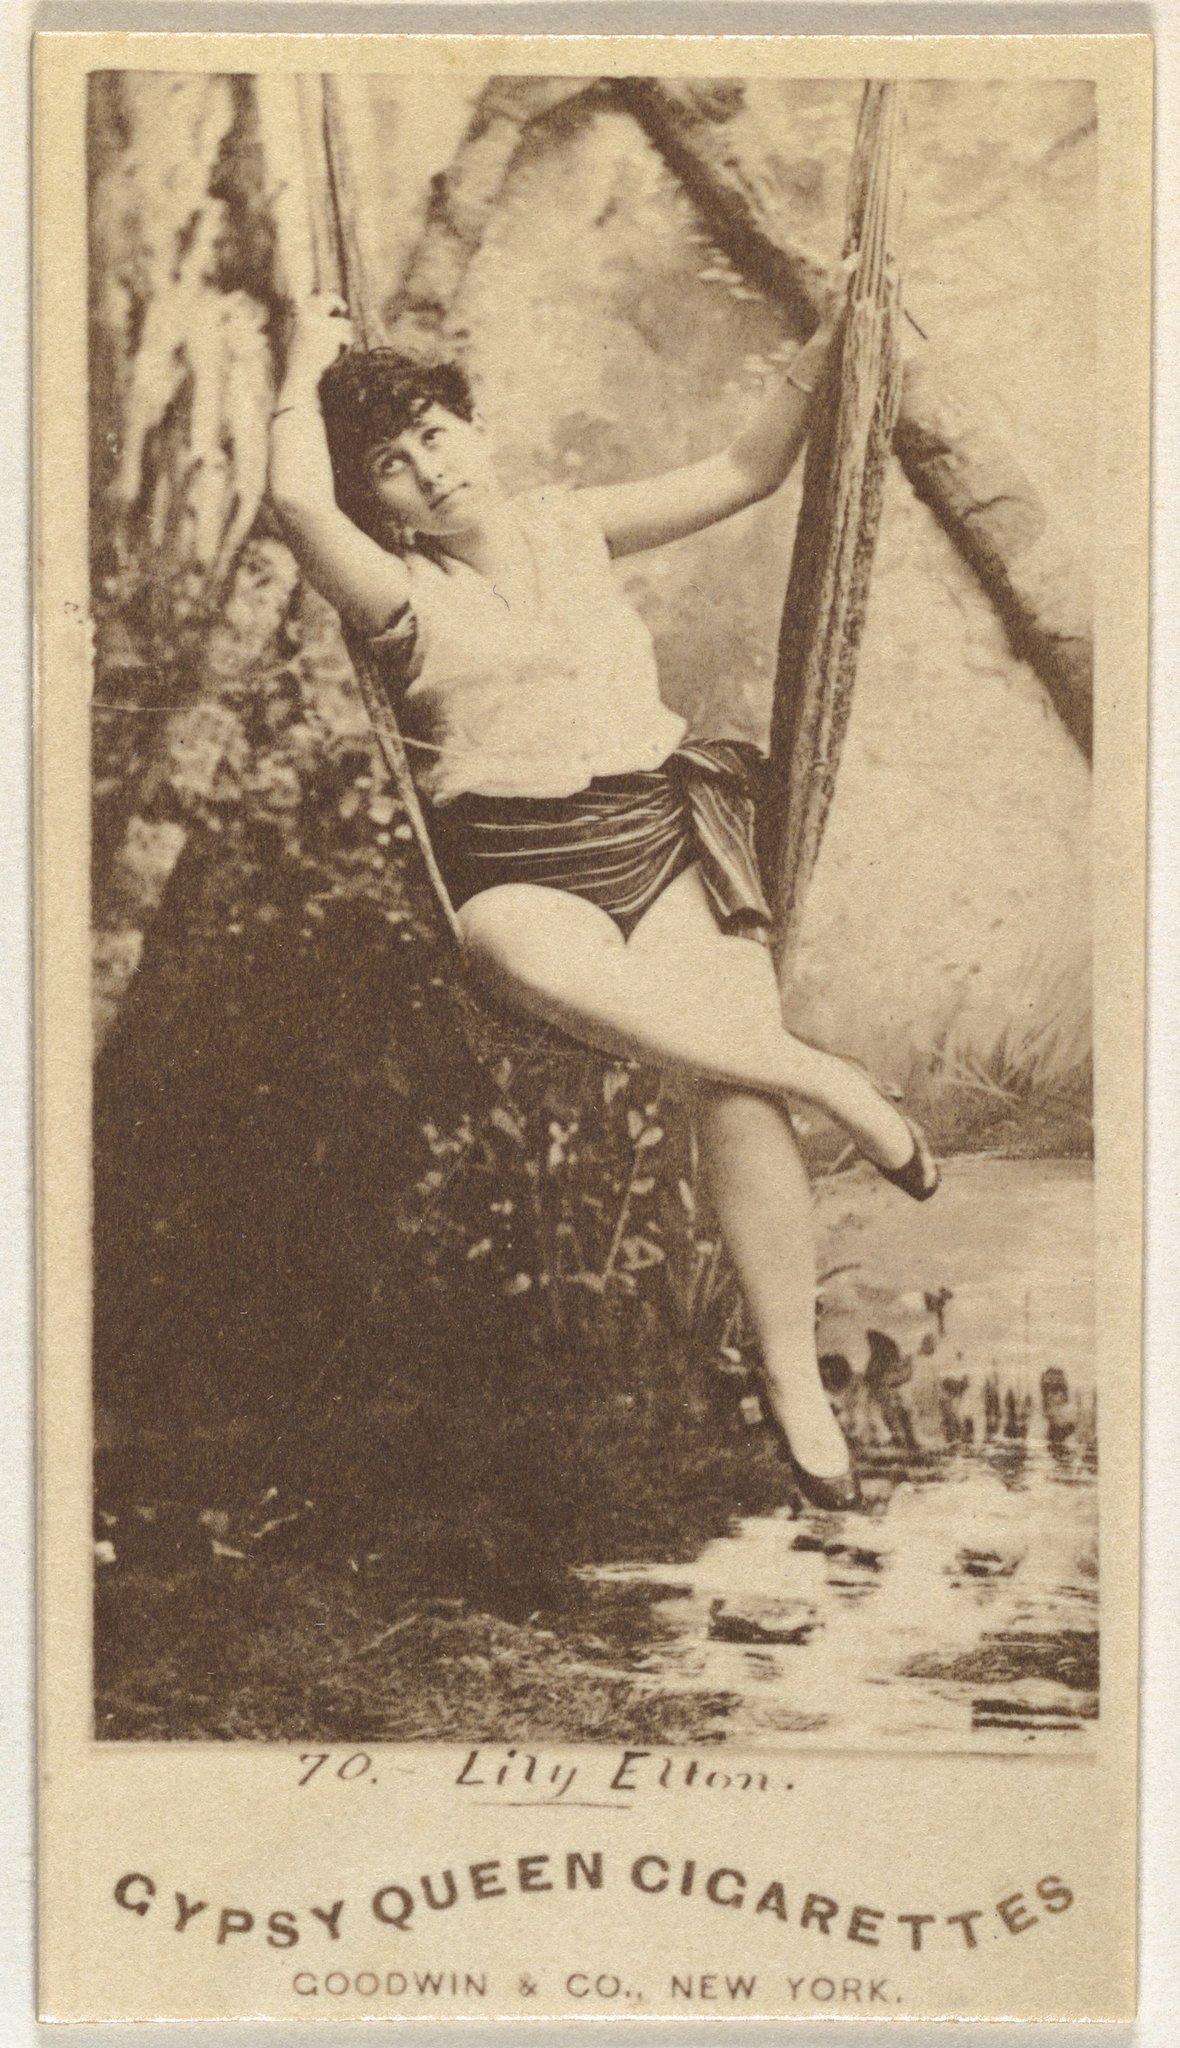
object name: photograph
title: Lily Elton, from the Actors and Actresses series (N171) for Gypsy Queen Cigarettes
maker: goodwin & company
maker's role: publisher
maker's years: 1850-1950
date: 1886-1890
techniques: albumen silver print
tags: portraits,women,actresses